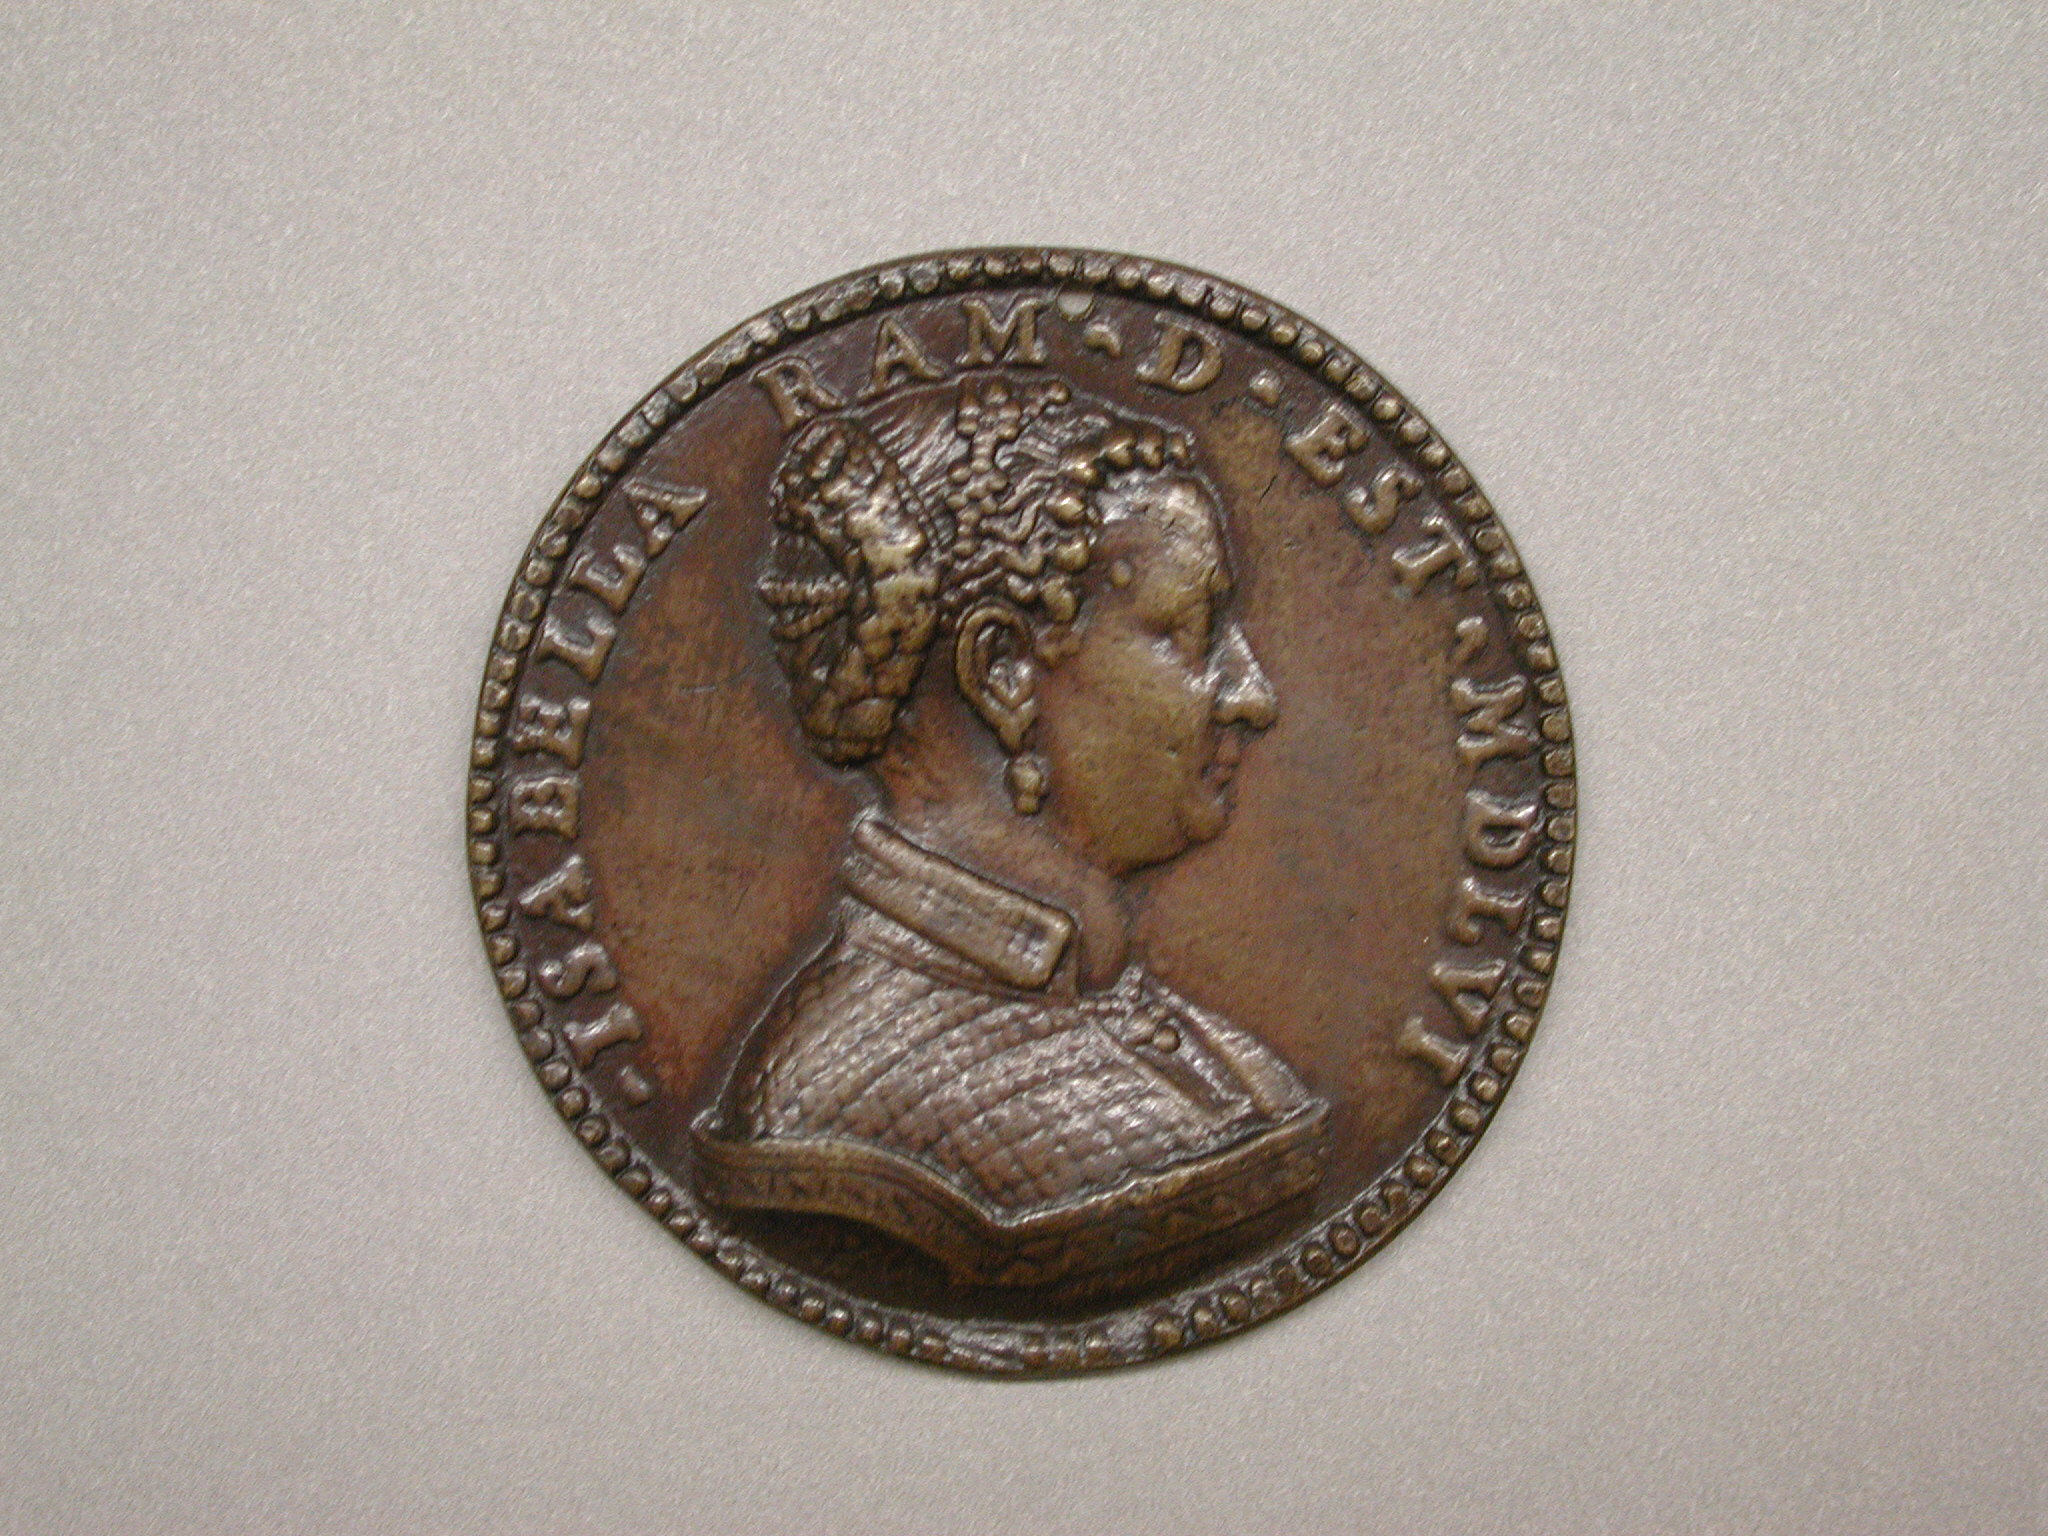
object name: medal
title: Isabella Rammi d'Este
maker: pastorino di giovan michele de' pastorini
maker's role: artist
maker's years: 1508-1592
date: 1556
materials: bronze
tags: profiles,women